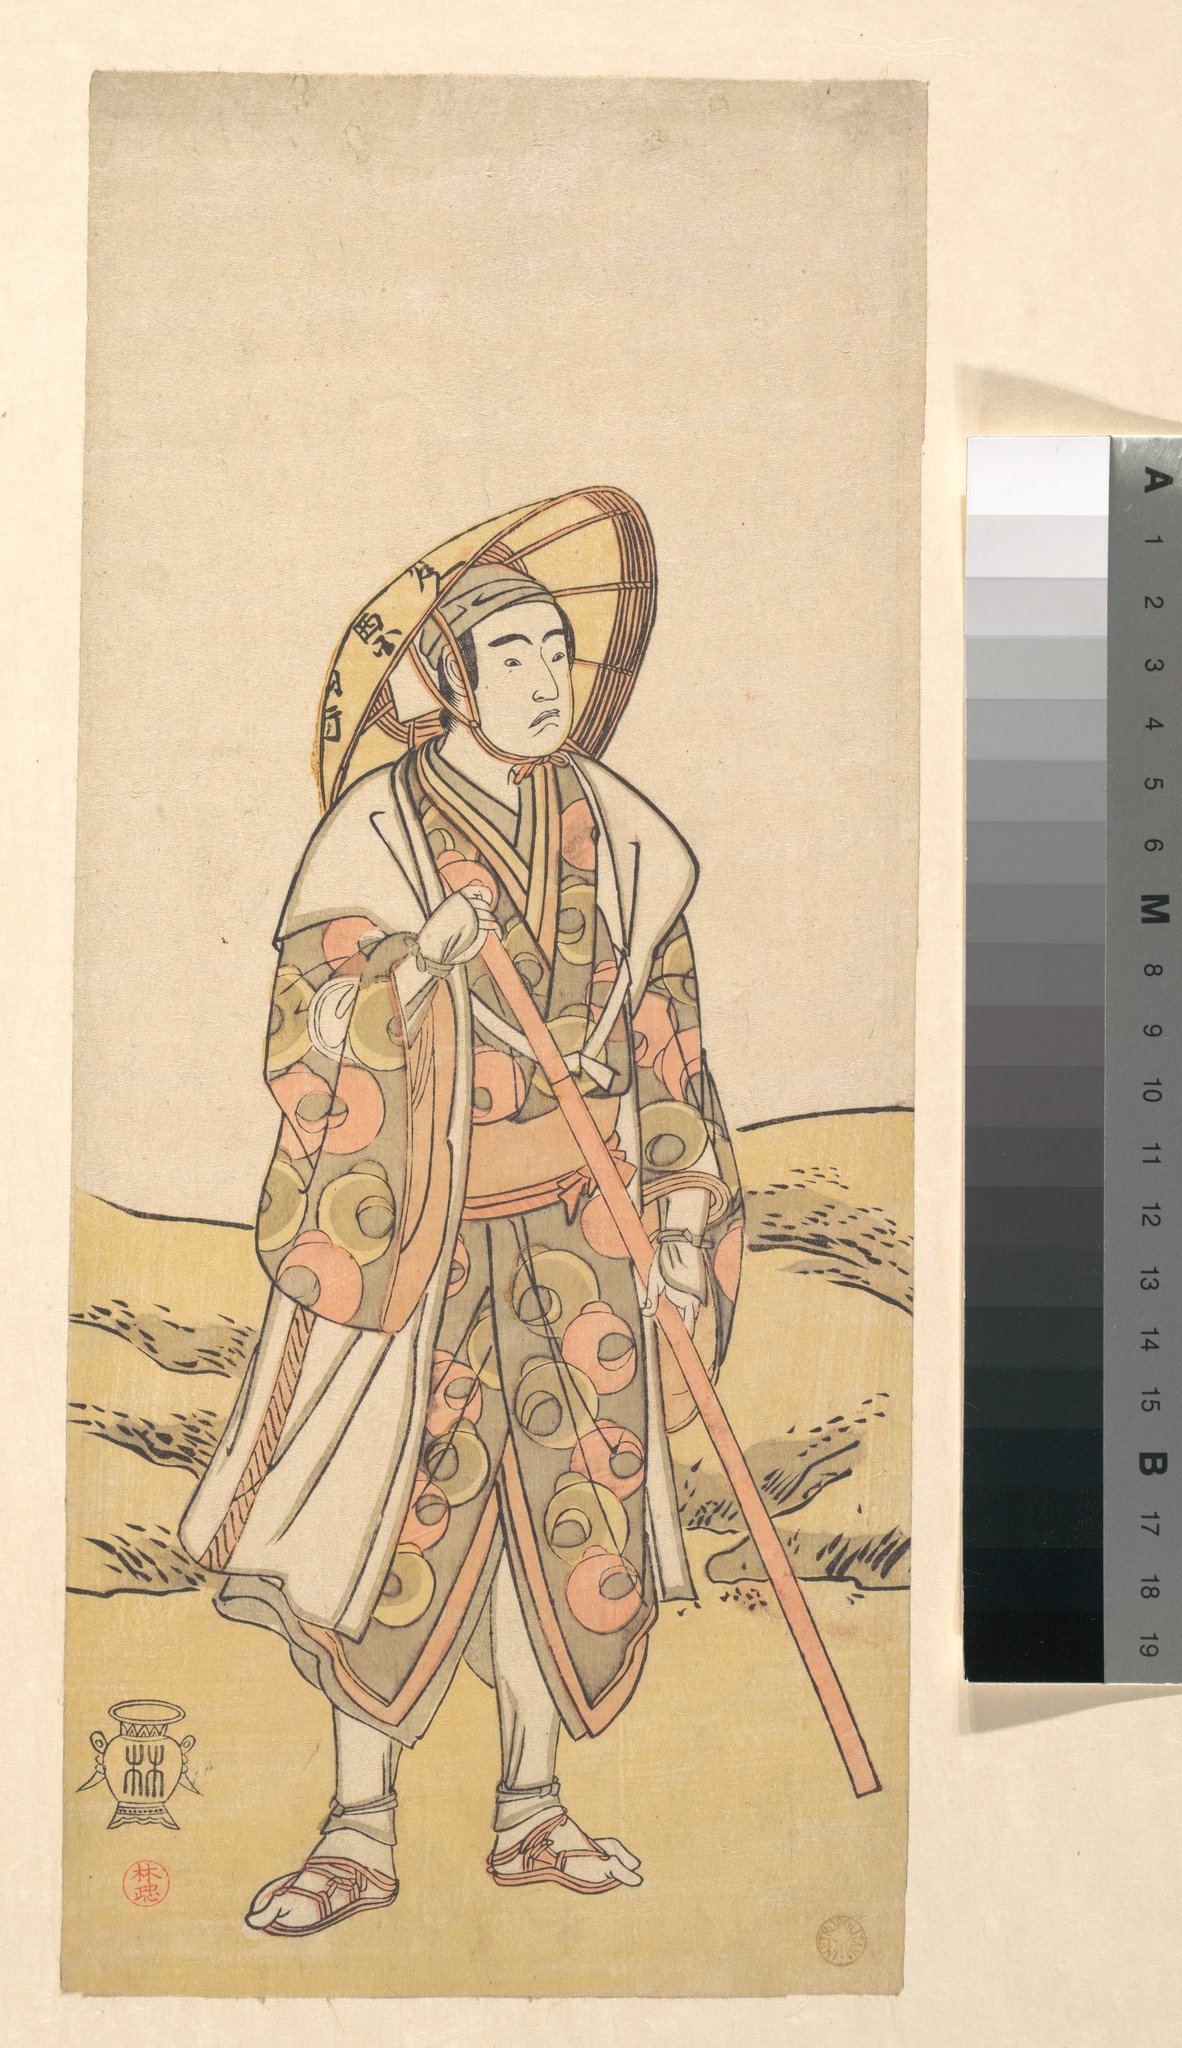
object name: woodblock print nishiki e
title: The Actor Sawamura Sōjūrō III as the Kumano Pilgrim Jissaku, actually Taira no Shigemori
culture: japanese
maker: katsukawa shunshō 勝川春章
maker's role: artist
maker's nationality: japanese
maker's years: 1726-1792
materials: ink, paper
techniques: nishiki e, woodblock print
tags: hats,men,actors